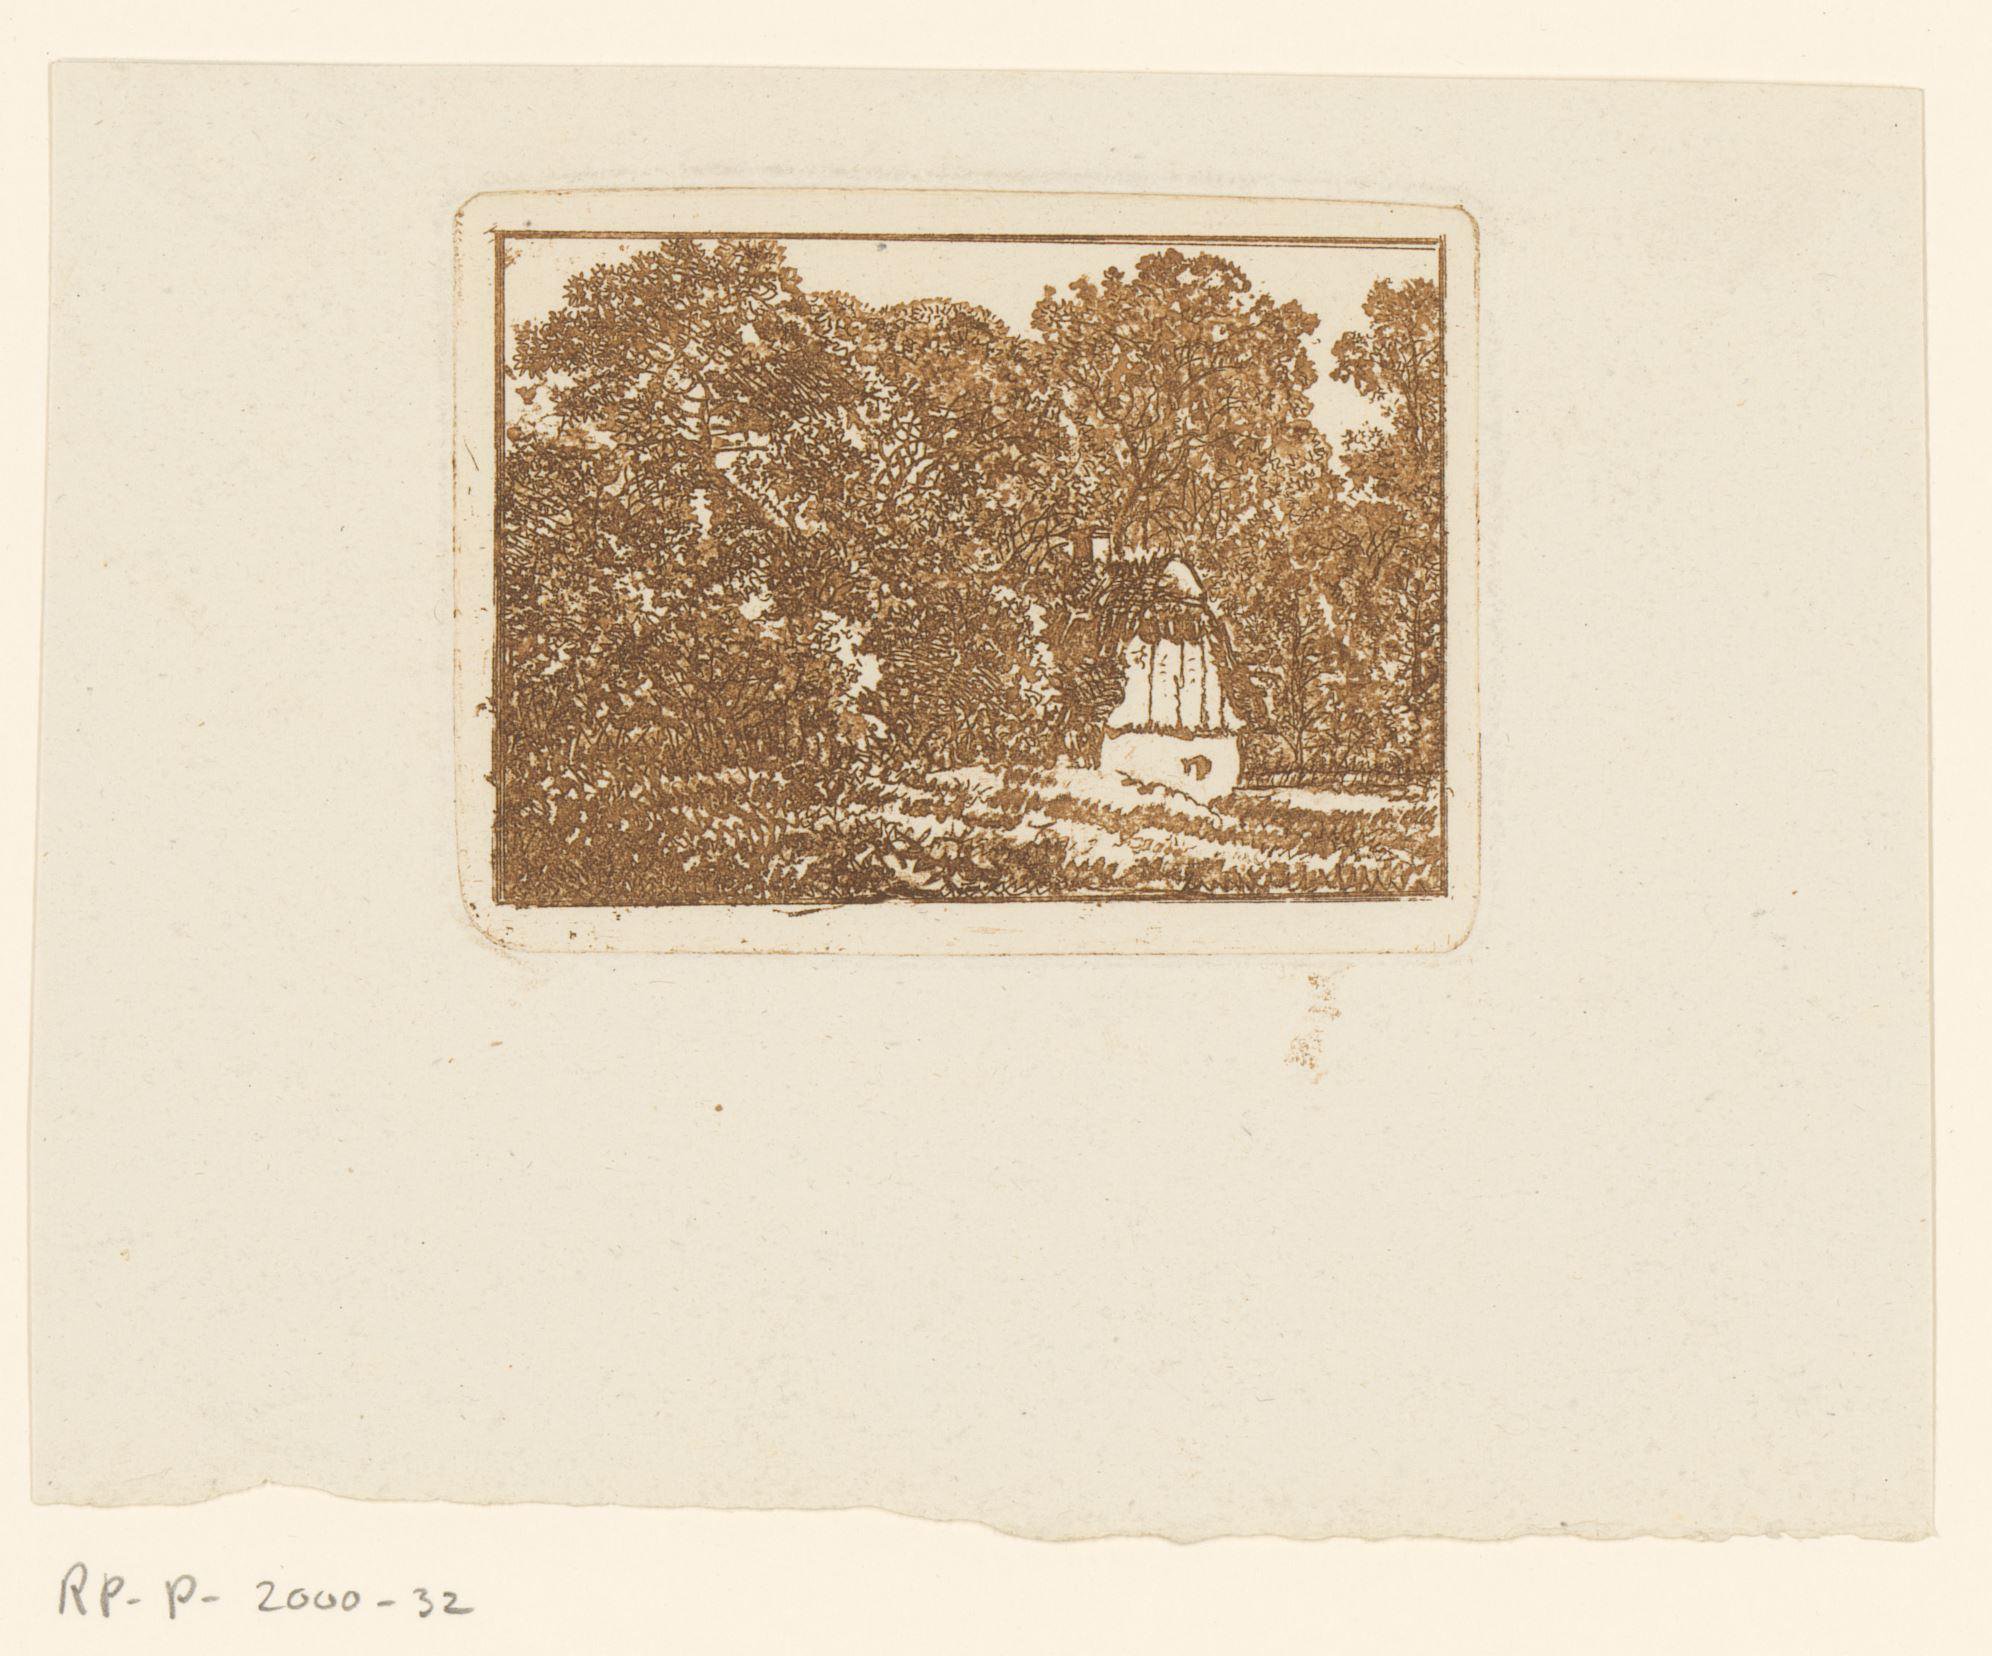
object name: print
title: Boerenhut in bos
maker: christoph nathe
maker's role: print maker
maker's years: 1753-1806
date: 1780-1806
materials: paper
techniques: aquatint, etching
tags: landscapes, hut, cabin, lodge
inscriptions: collector's mark: Lugt 2228, collector's mark: Lugt 3870, collector's mark: Lugt 2760